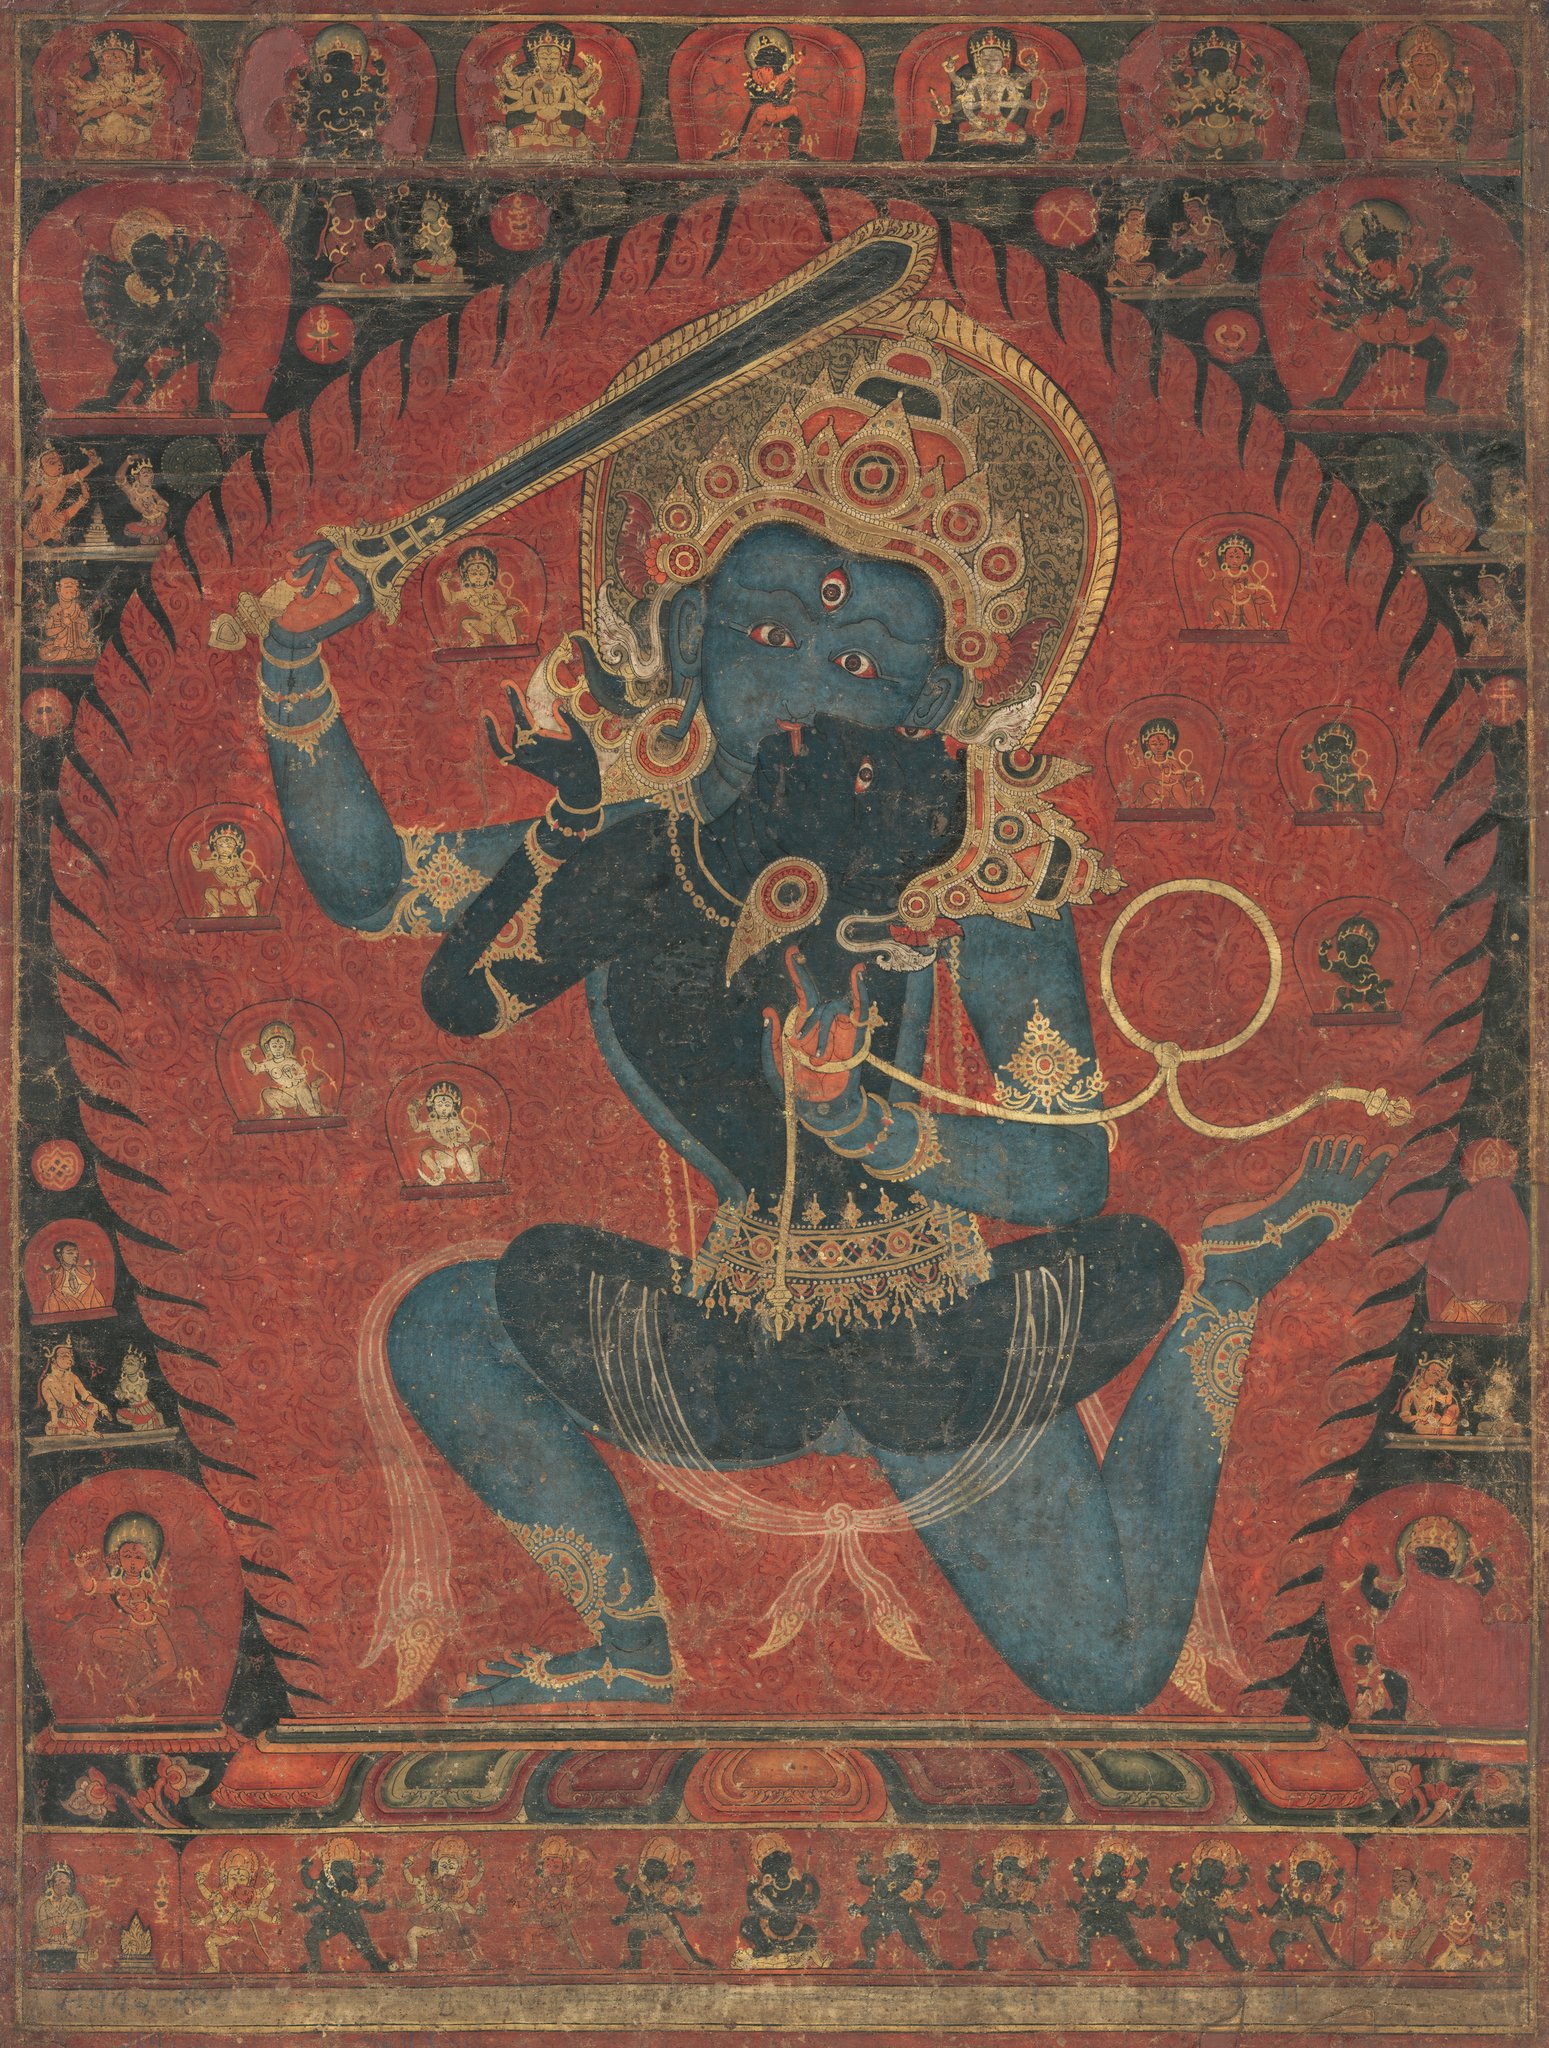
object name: thangka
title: Achala with His Consort Vishvavajri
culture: nepali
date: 1525-1550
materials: textile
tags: swords,couples,women,buddhism,bodhisattvas,manjushri